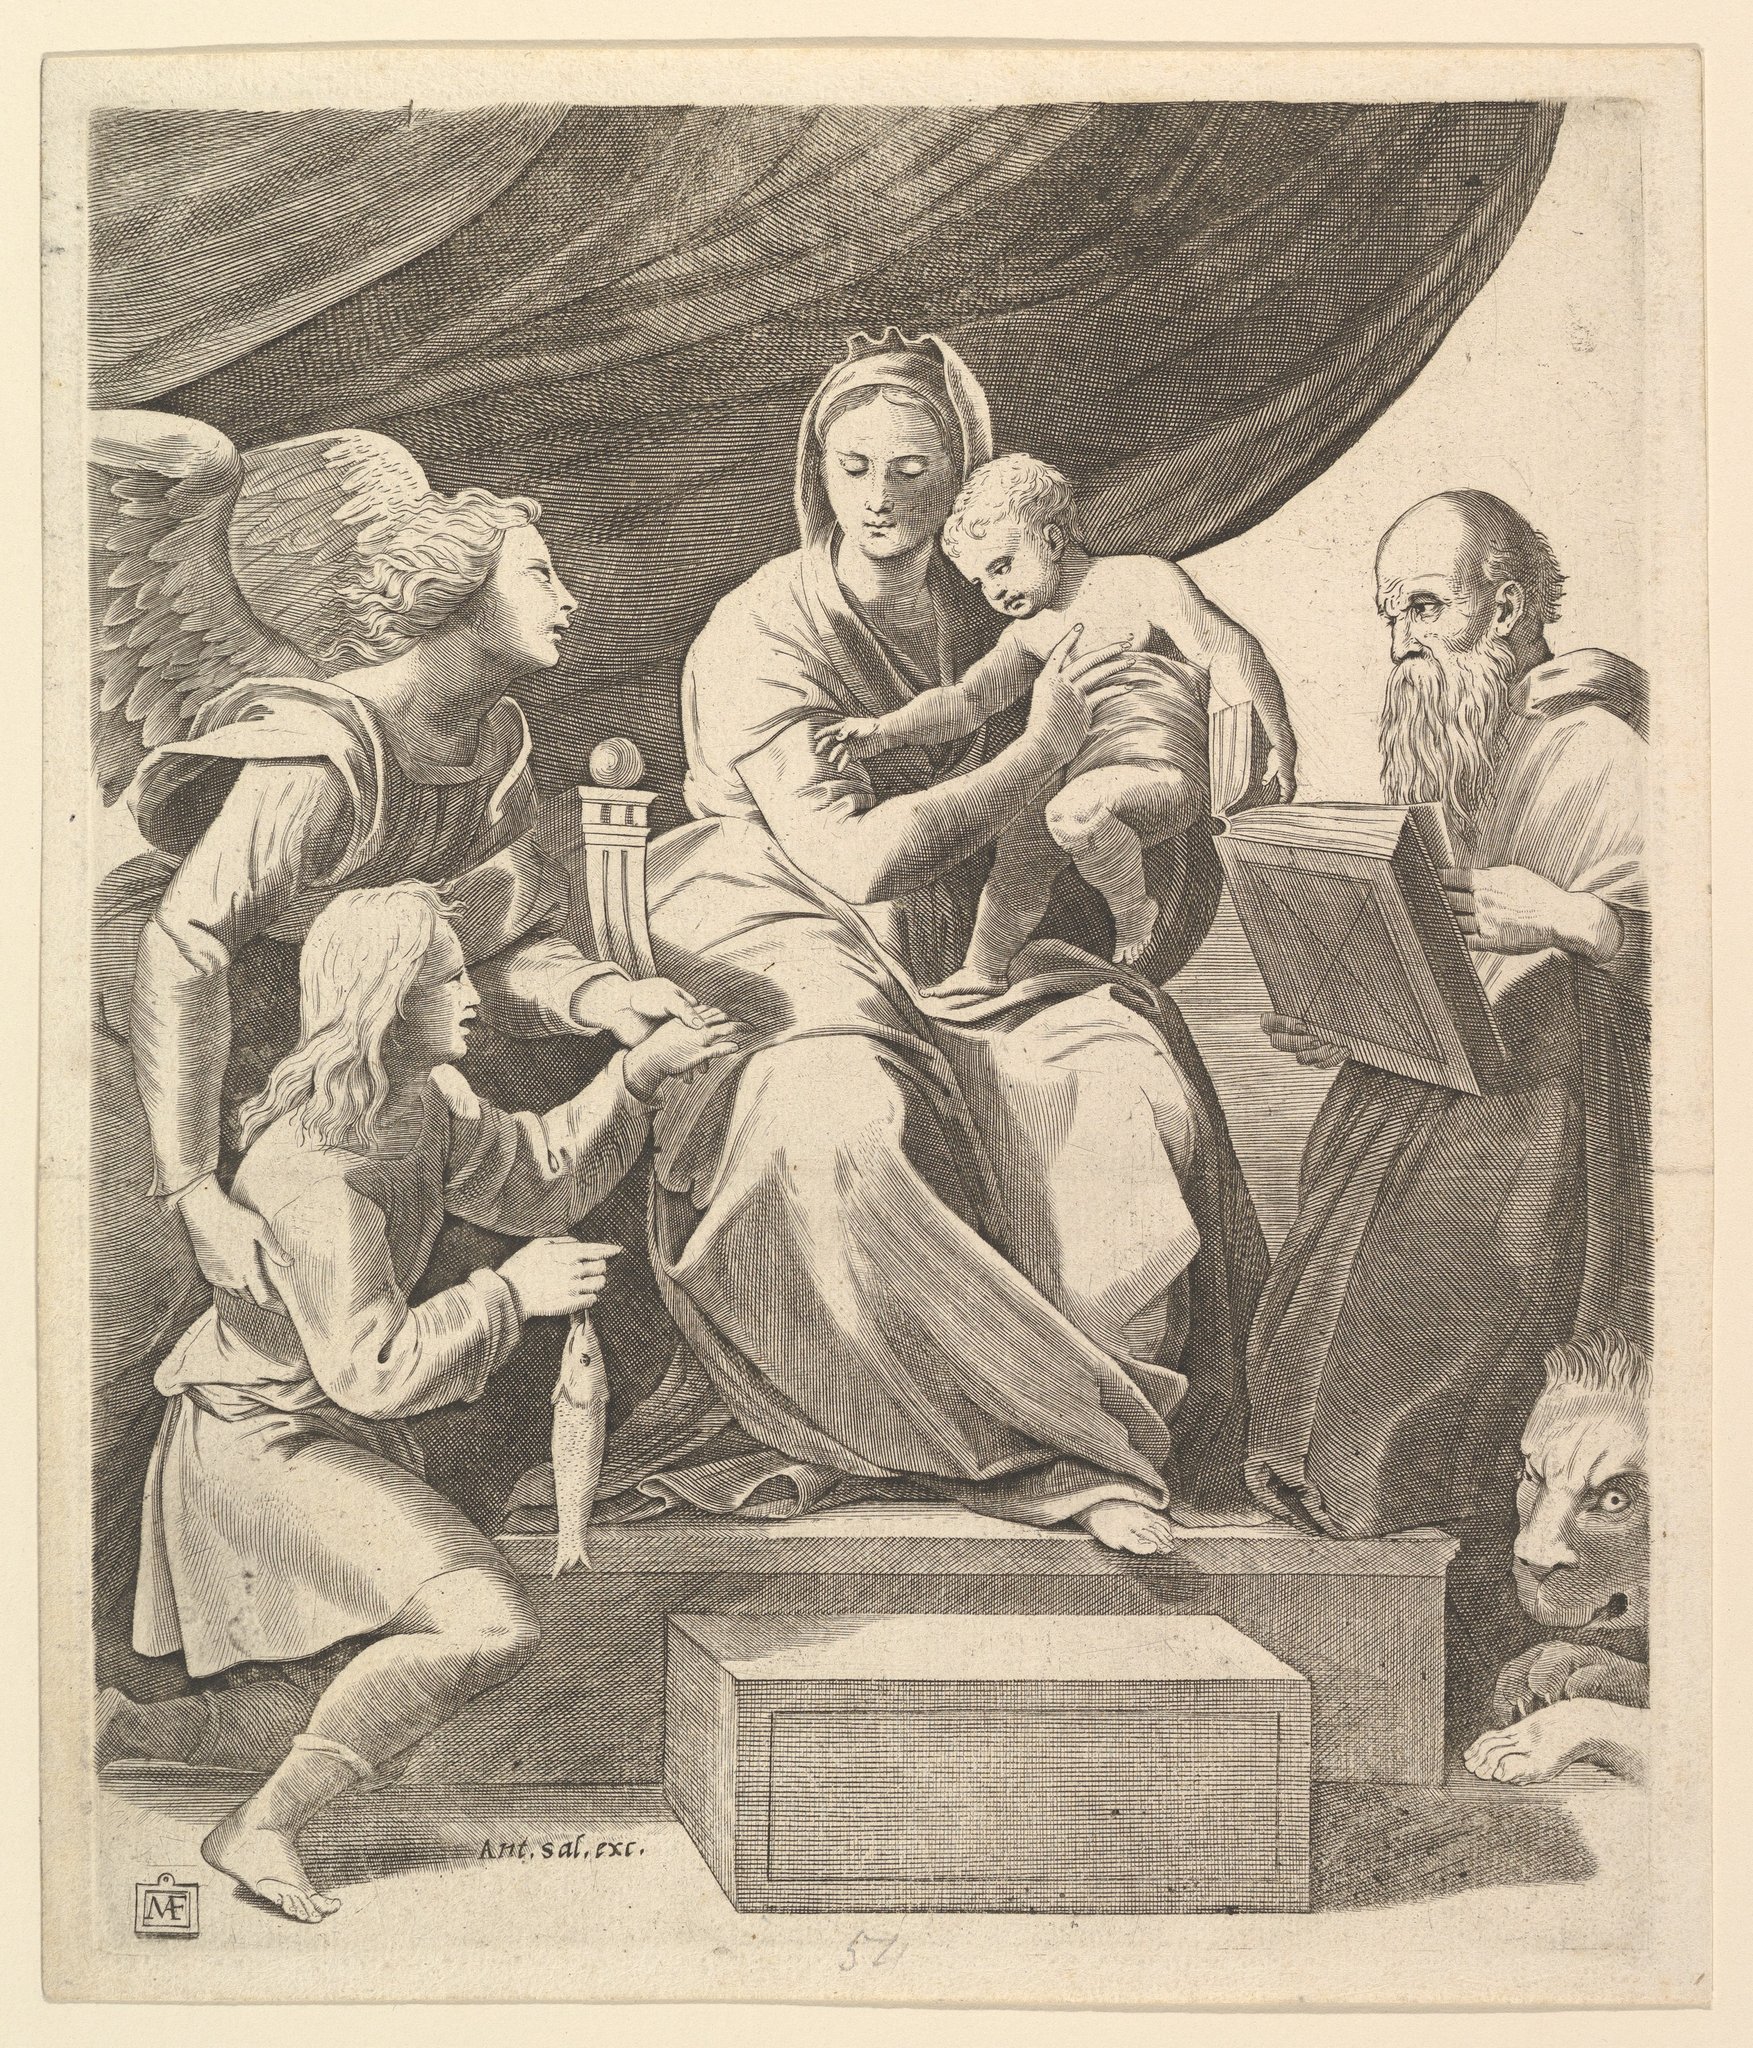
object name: print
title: The Virgin of the Fish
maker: marcantonio raimondi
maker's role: artist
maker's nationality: italian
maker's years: 1475-1534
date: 1500-1550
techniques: engraving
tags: men,fish,angels,virgin mary,jesus